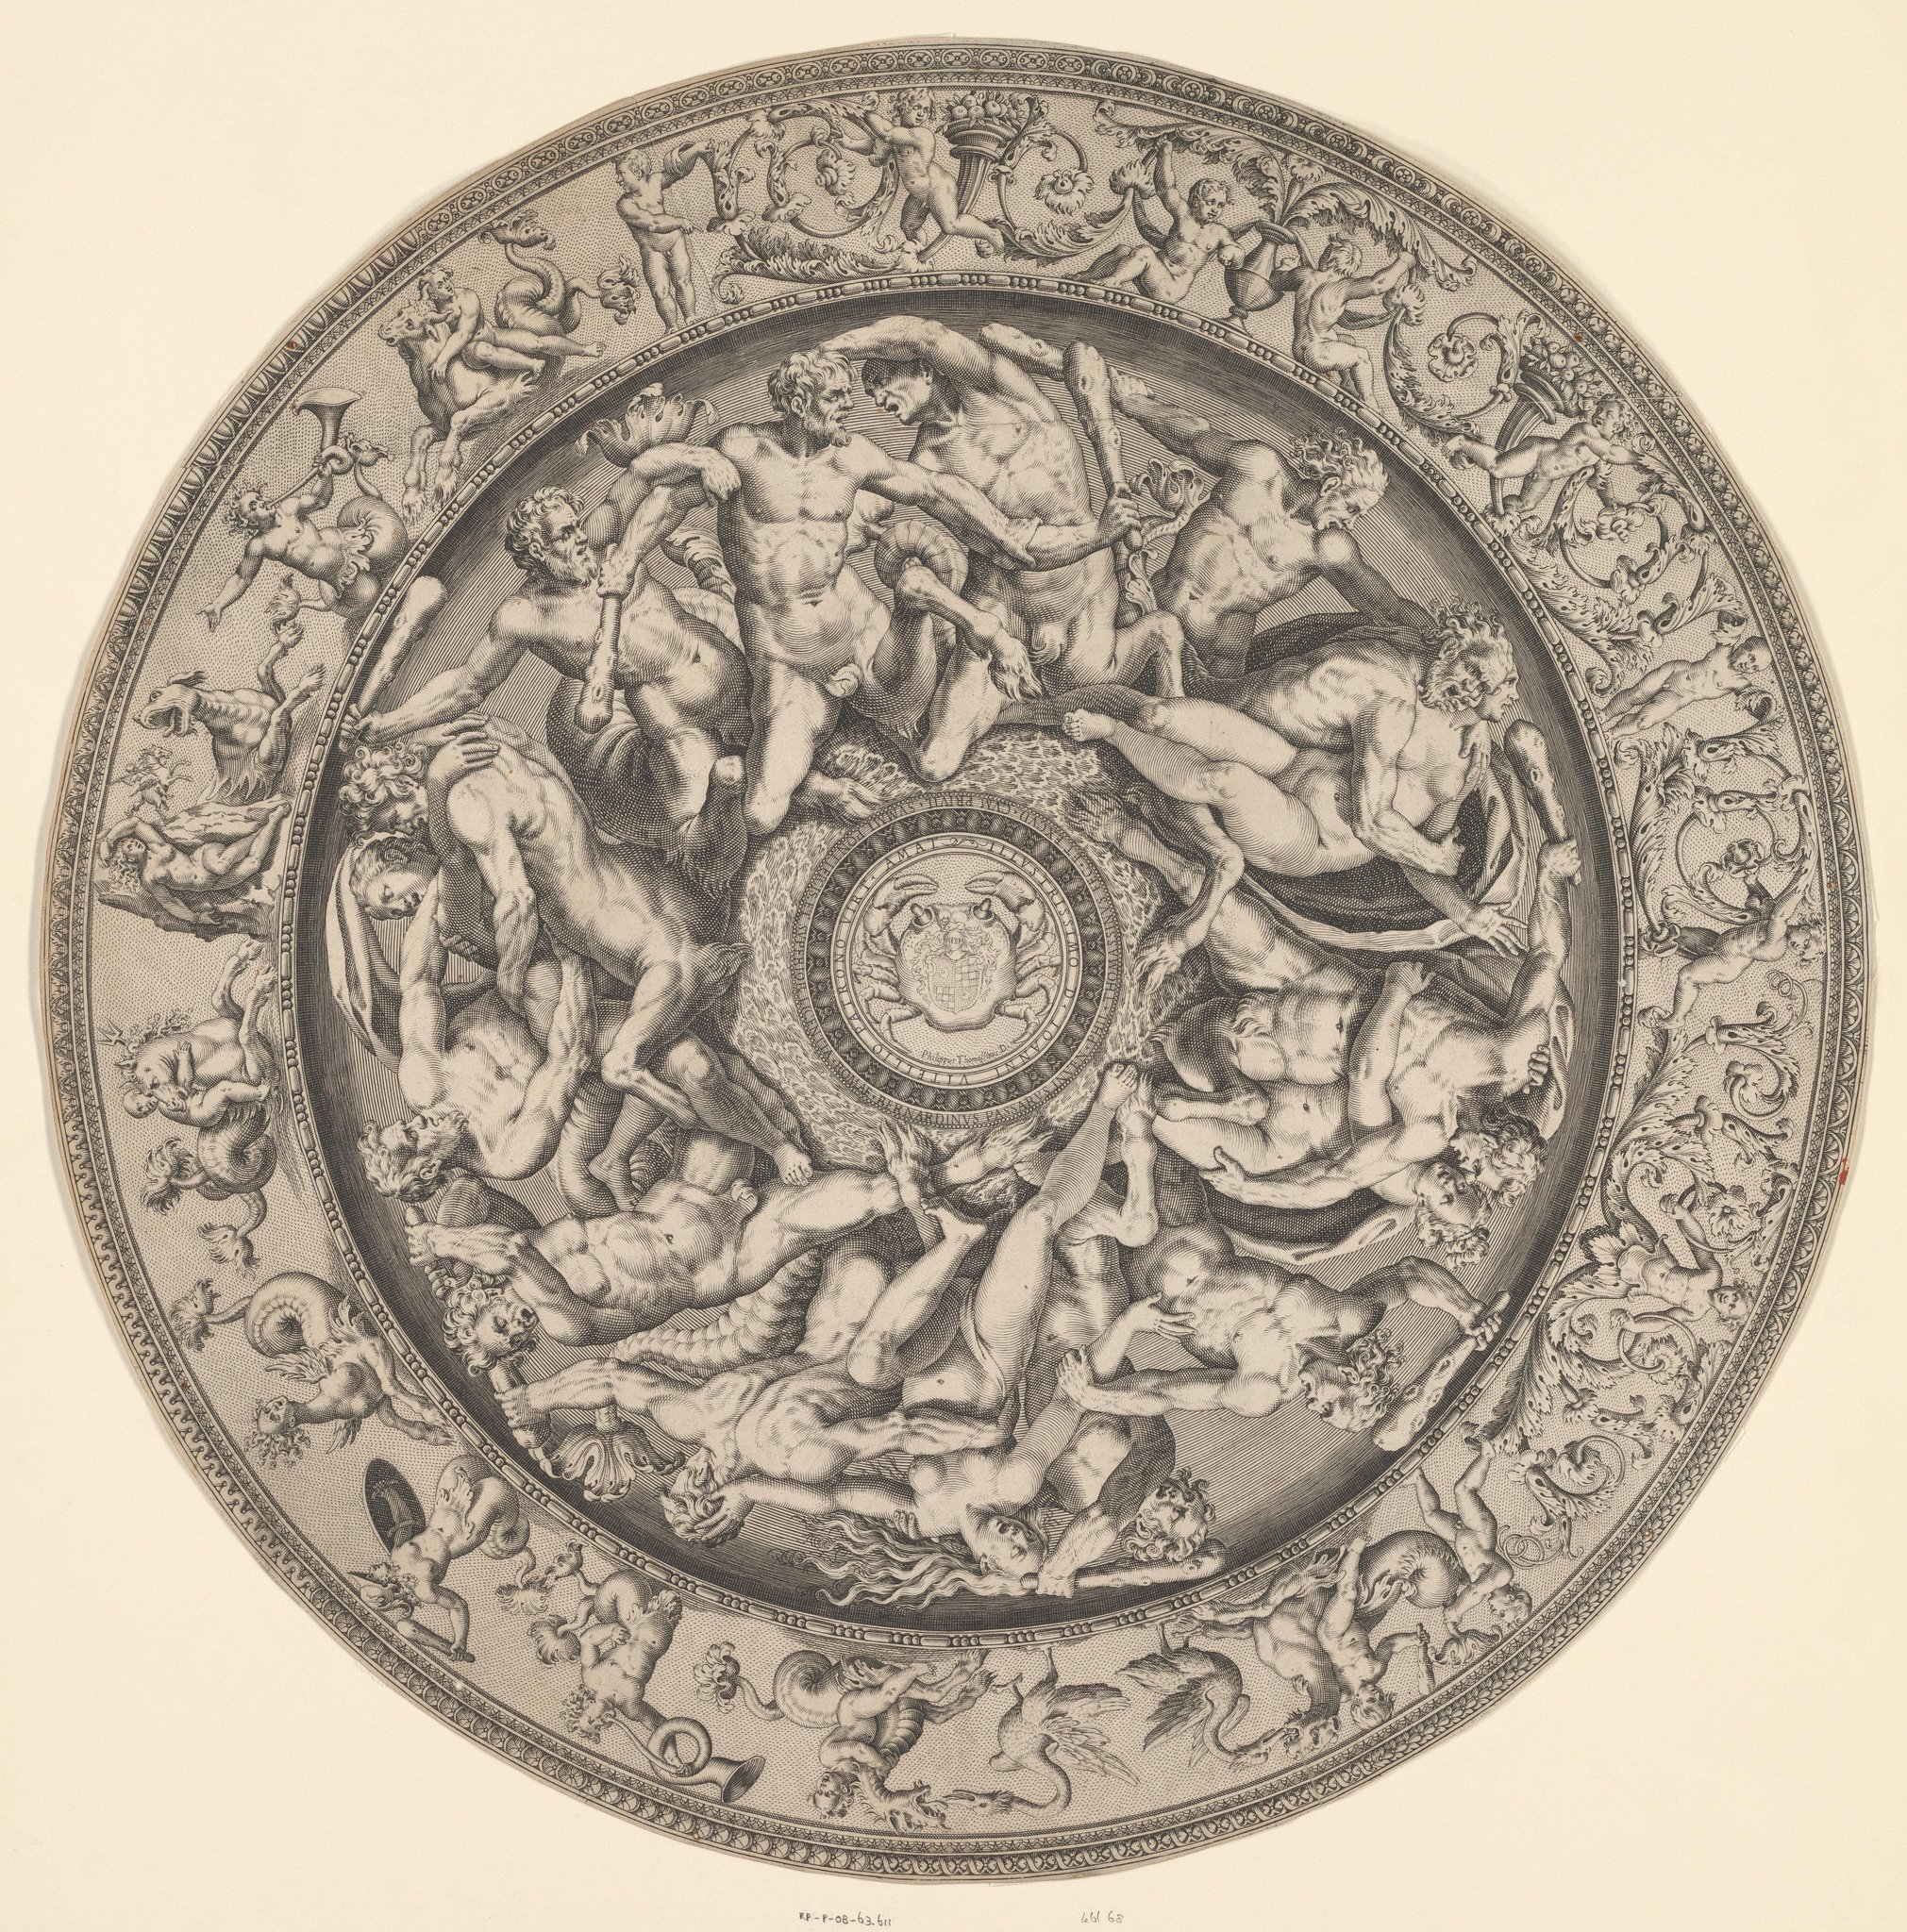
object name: print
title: Gevecht tussen de Centaurs en Tritons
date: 1572-1622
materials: paper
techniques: engraving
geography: rome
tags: protective weapons: shield, (story of) triton - aggressive, unfriendly activities and relationships, centaurs (+ aggressive, unfriendly activities and relationships), crustaceans: crab, cupids: 'amores', 'amoretti', 'putti'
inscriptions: : ‘supior licentia . Romae.’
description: Mogelijk een schild met daarop in het midden een krab. Daar omheen het gevecht tussen de Lapithen en Centauren, omringd door een ornamentele rand met putti en wezens uit de zee.